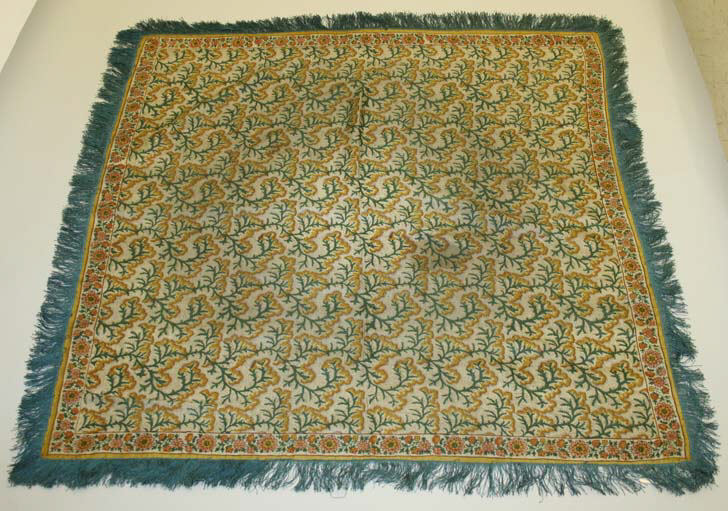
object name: scarf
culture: american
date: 1840-1849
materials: silk